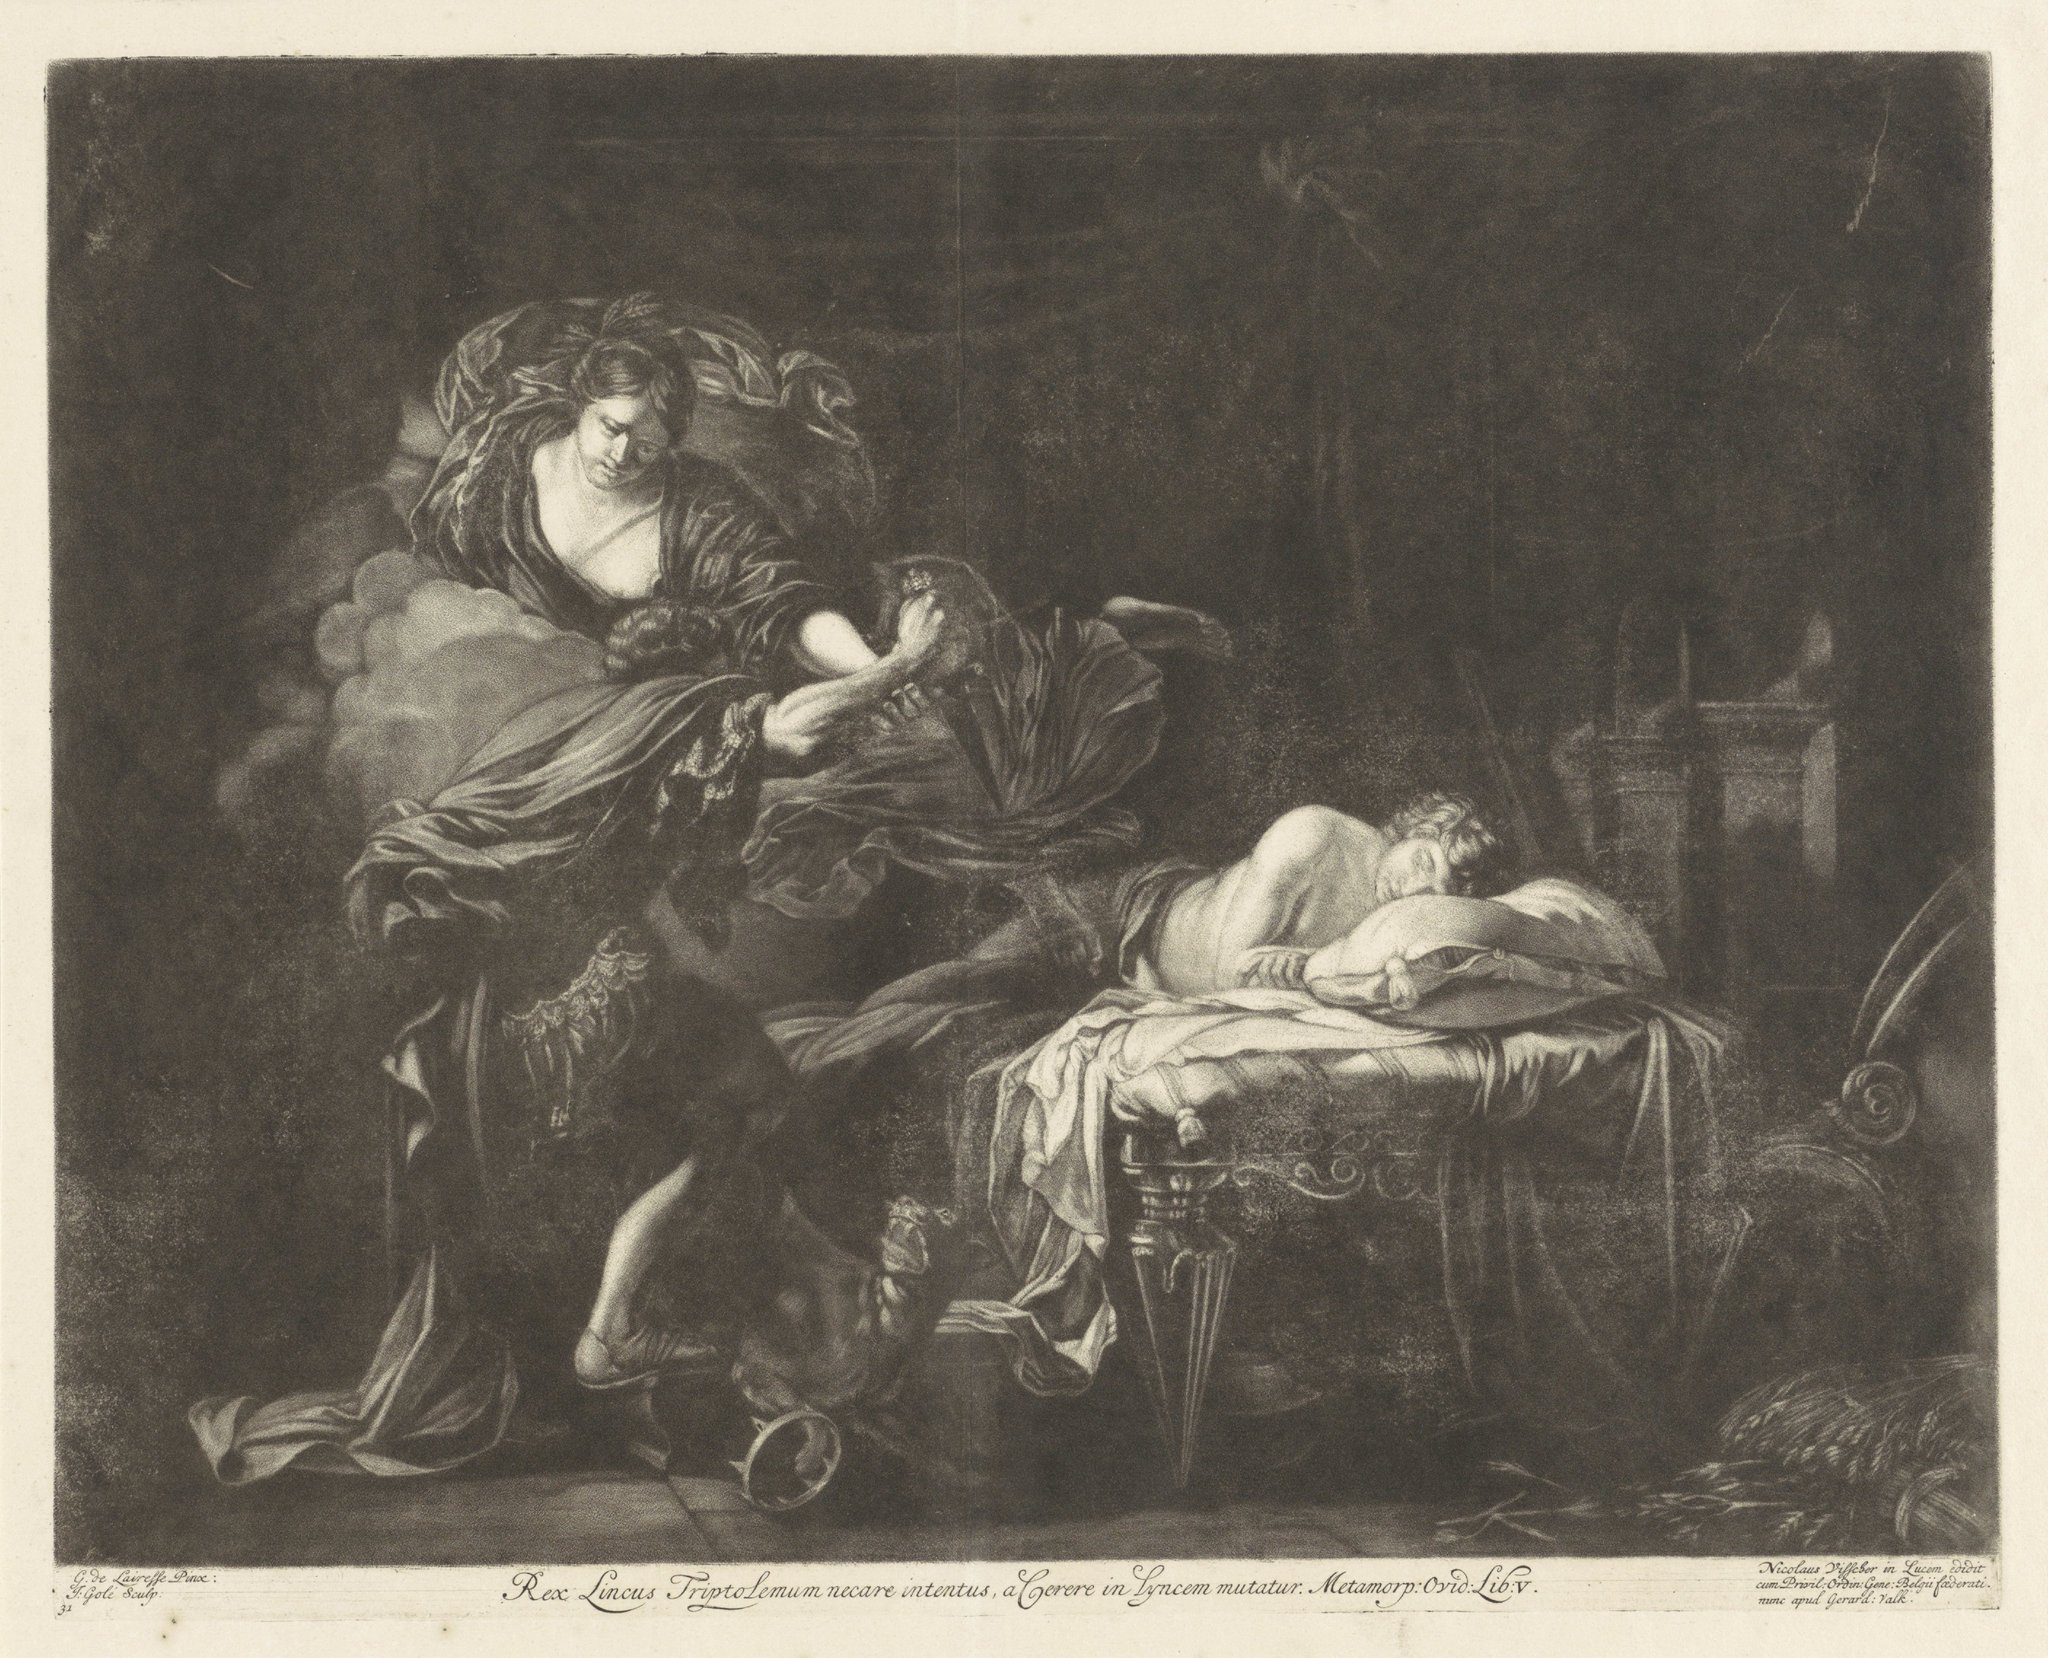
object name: print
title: Ceres verandert Lyncus in een lynx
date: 1670-1724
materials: paper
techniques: engraving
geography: amsterdam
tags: lyncus changed into a lynx: ceres changes lyncus into a lynx when he is on the point of murdering the sleeping triptolemus (ovid, metamorphoses v 657)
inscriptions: collector's mark: Lugt 2228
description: Ceres verandert Lyncus in een lynx omdat hij Triptolemus uit jaloezie probeert te doden in zijn slaap.